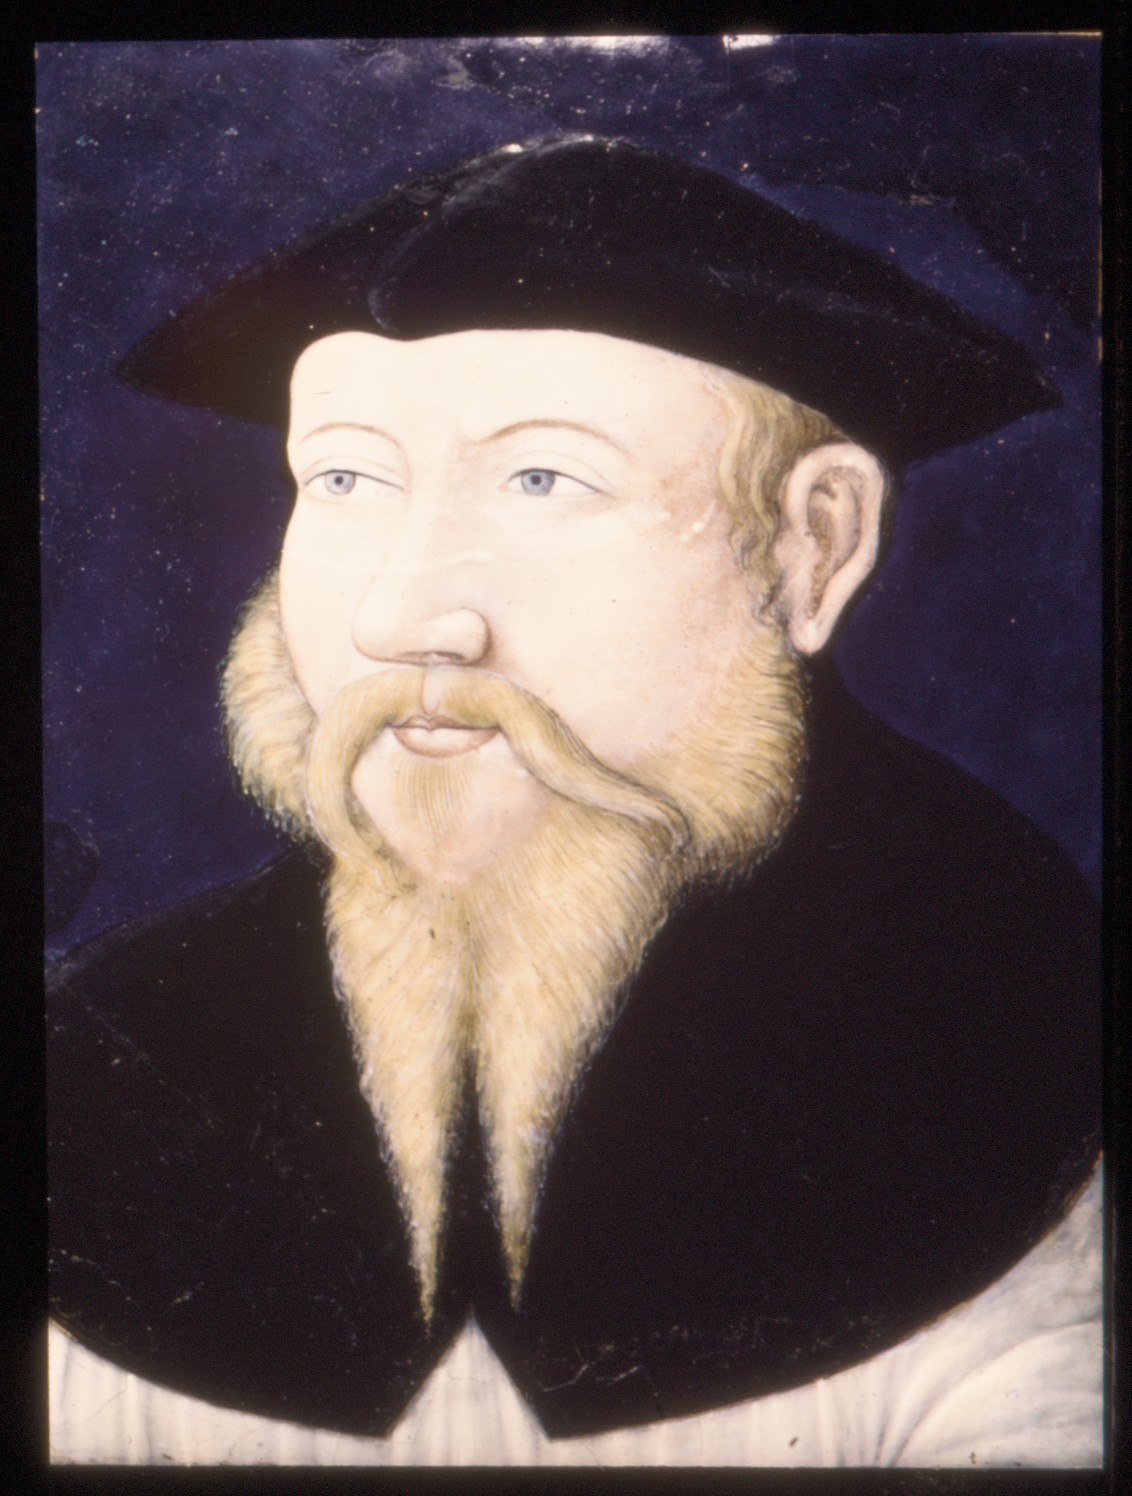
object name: plaque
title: Portrait of an unidentified gentleman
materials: copper, enamel, gilt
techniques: painting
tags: men,portraits